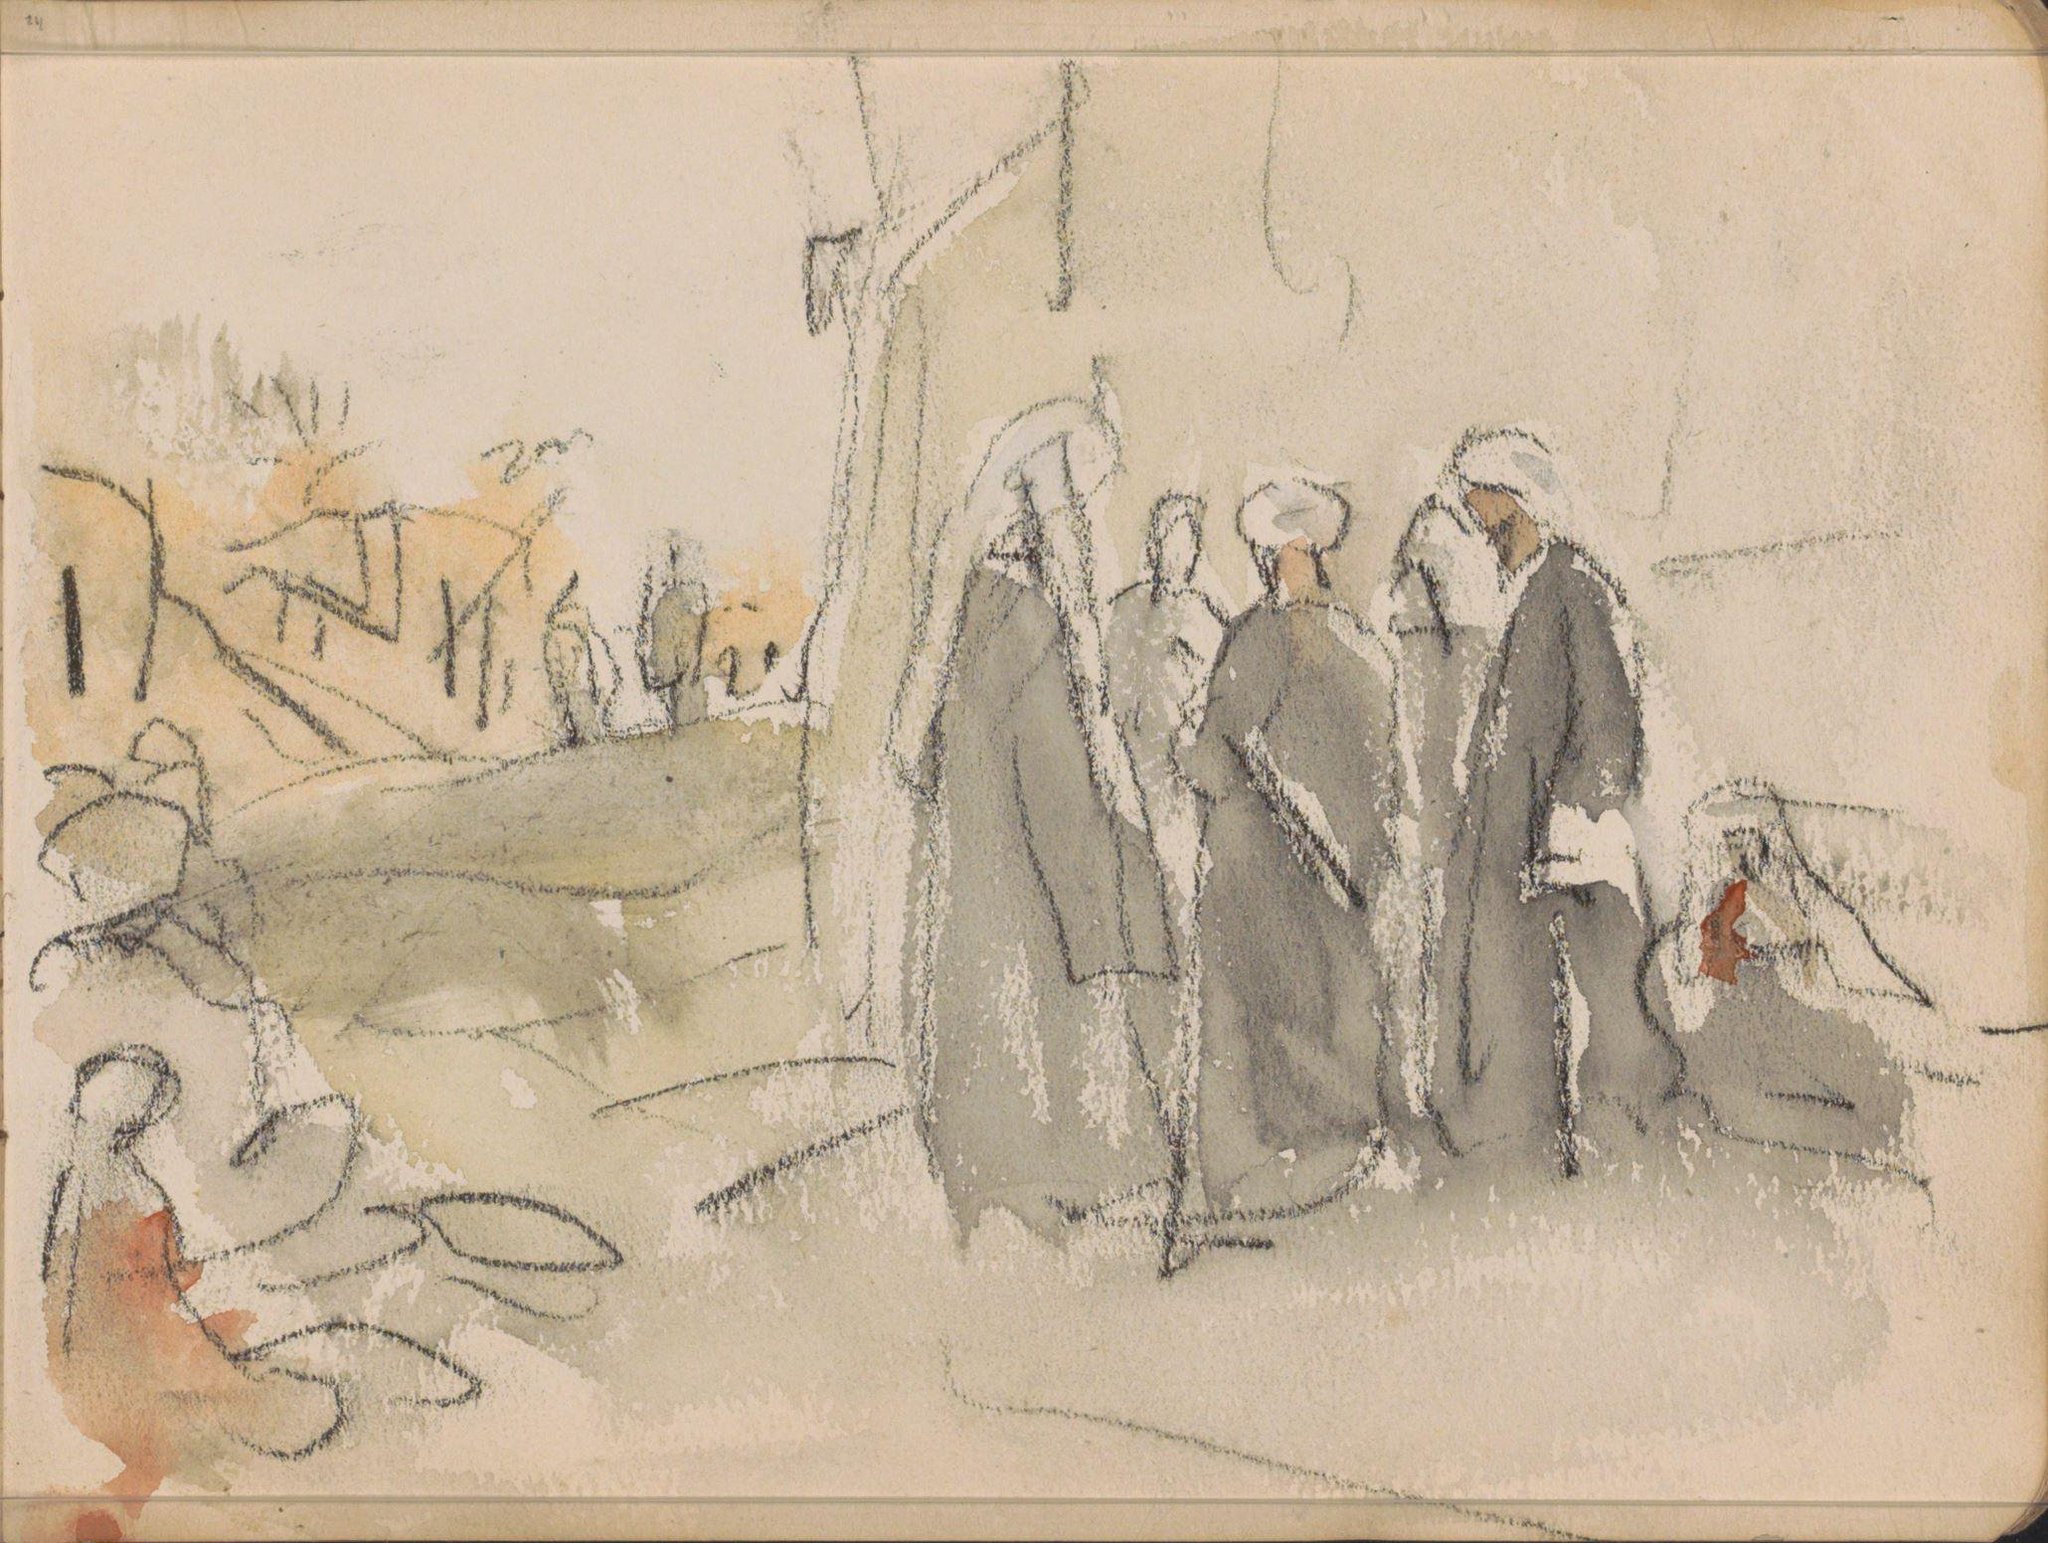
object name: sketchbook leaf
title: Egyptenaren op een straathoek in Luxor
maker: marius bauer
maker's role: draughtsman, print maker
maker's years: 1867-1932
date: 1919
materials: chalk, paper, watercolor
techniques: brush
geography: luxor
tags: africans, street (+ city(-scape) with figures, staffage)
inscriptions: kleurnotitie, handgeschreven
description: Pagina 24 uit een schetsboek met 28 bladen.